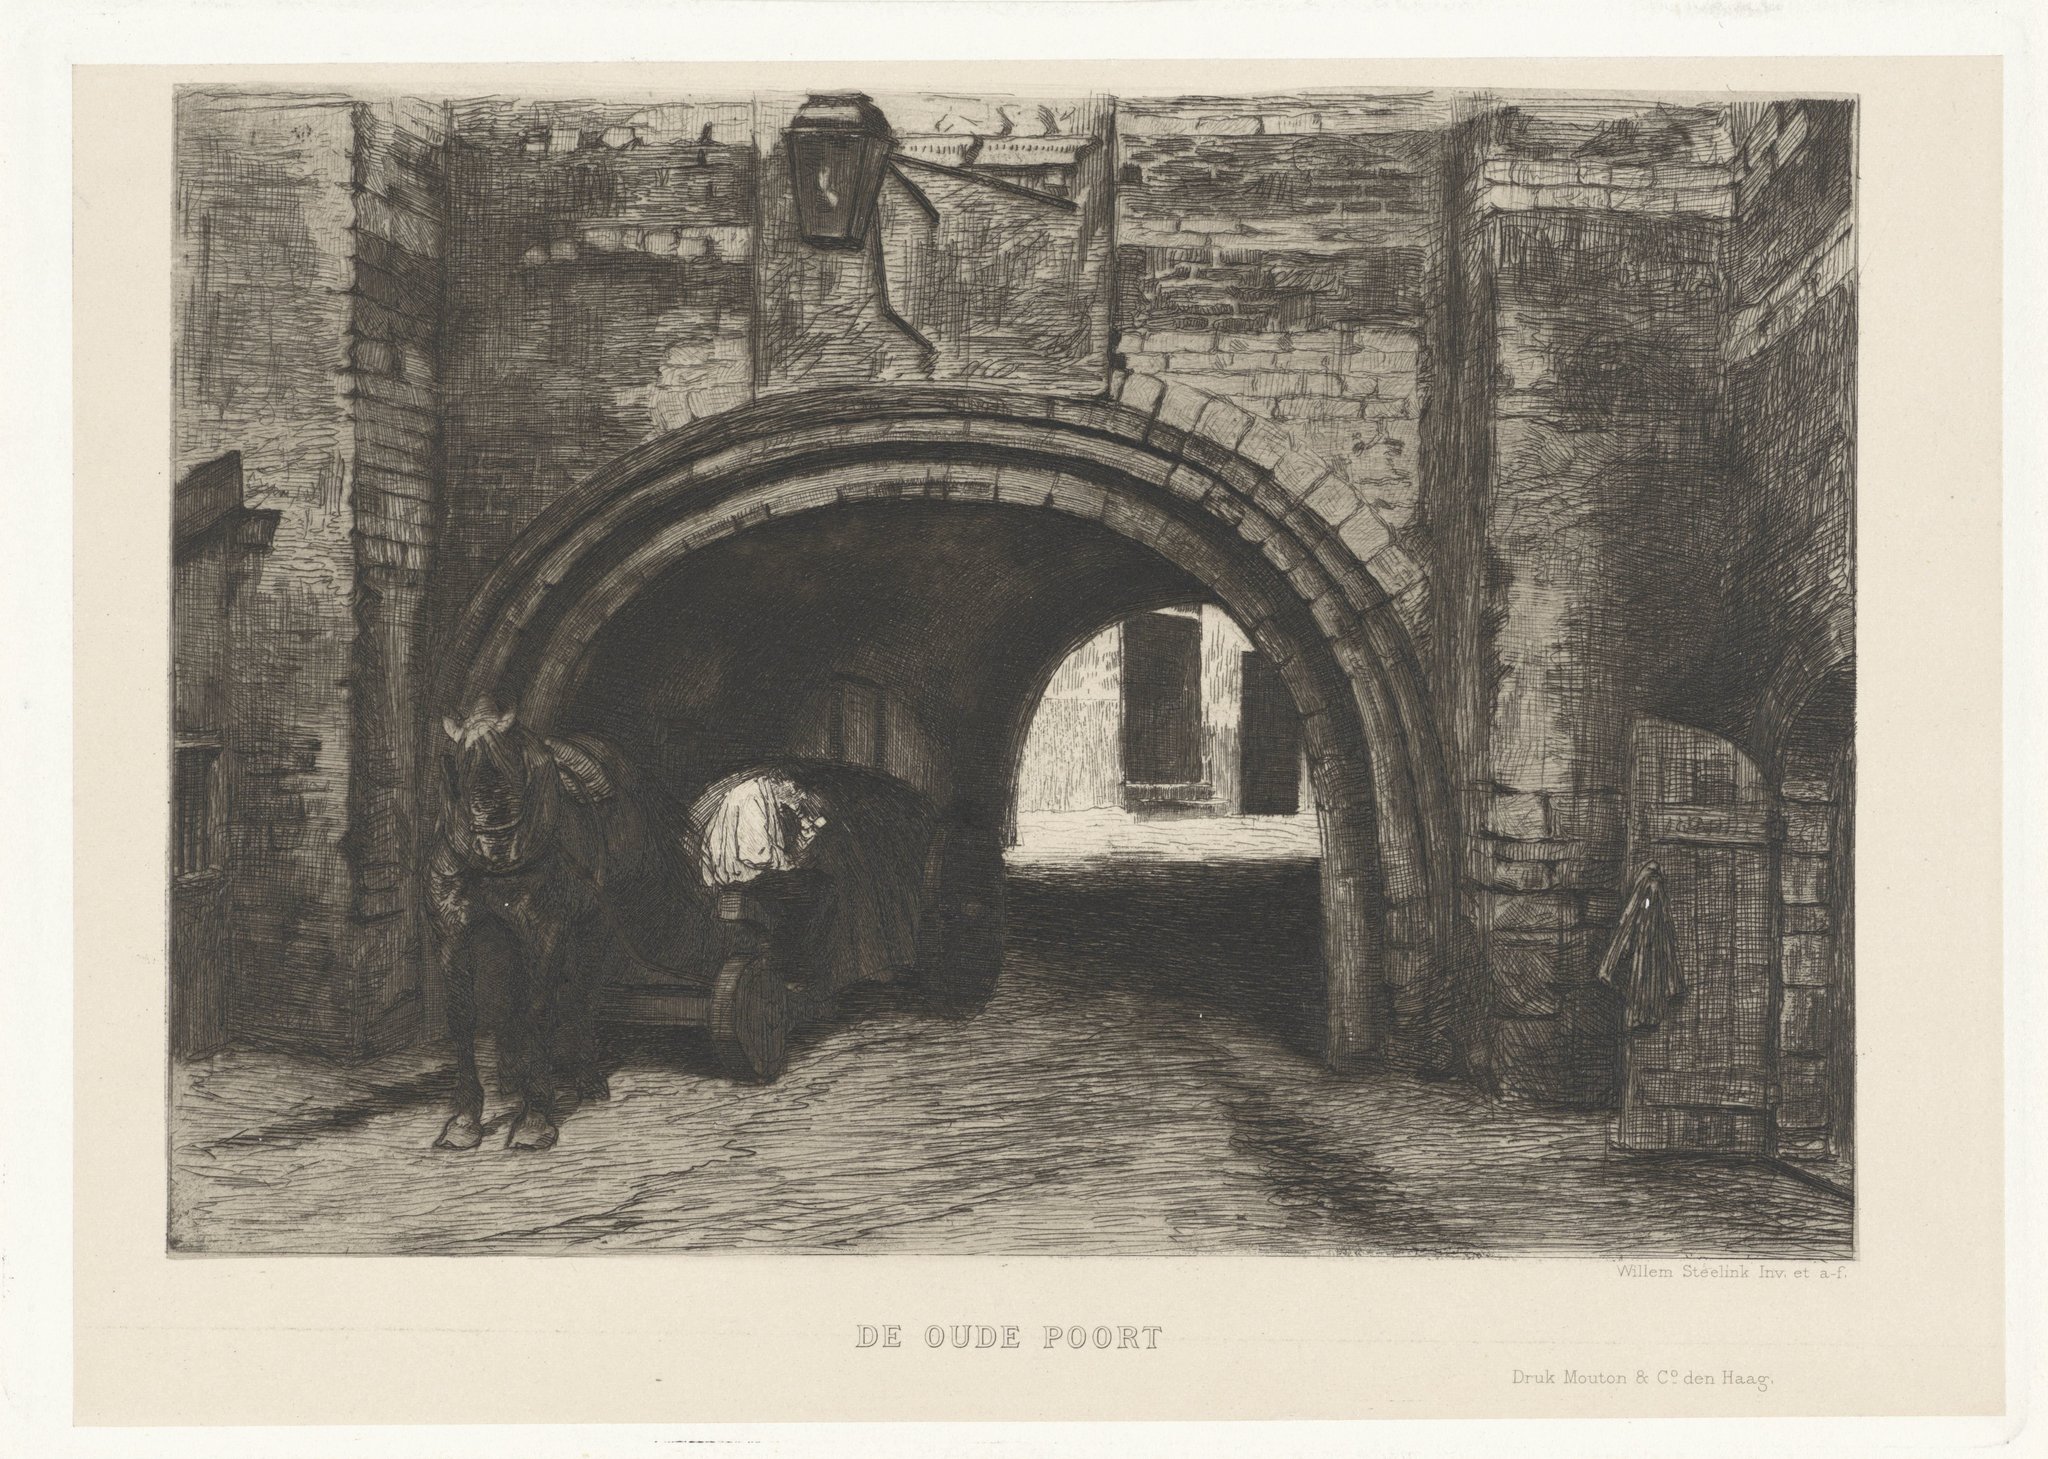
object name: print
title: De oude poort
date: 1889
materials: paper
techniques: etching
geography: amsterdam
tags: four-wheeled vehicle drawn by one animal, gate, entrance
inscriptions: collector's mark: Lugt 2228